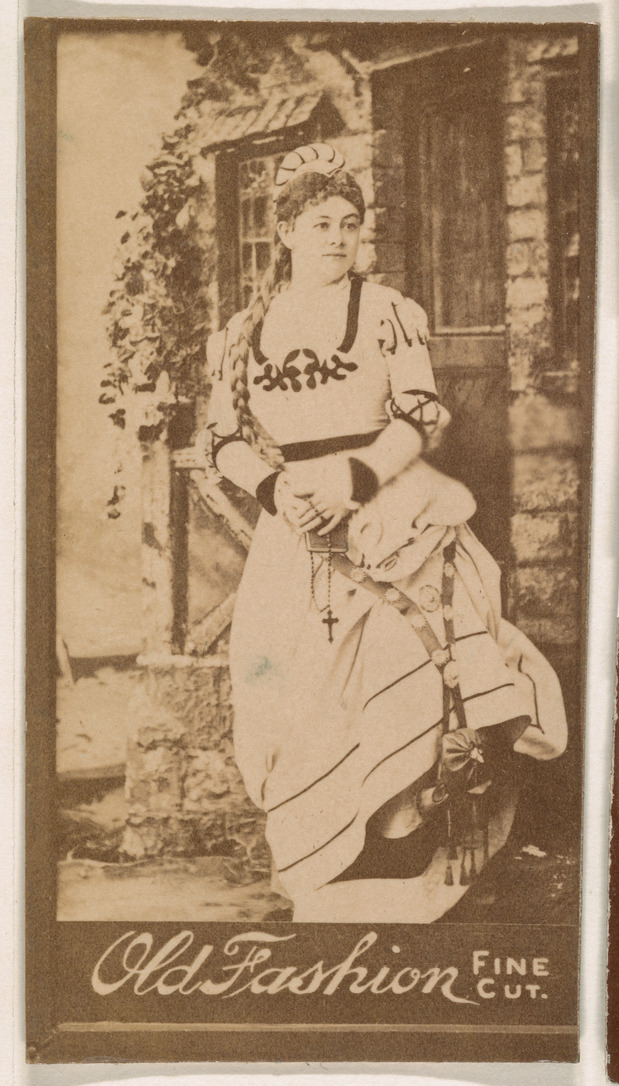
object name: photograph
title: Actress with long braid, from the Actresses series (N664) promoting Old Fashion Fine Cut Tobacco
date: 1888-1890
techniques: albumen silver print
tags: portraits,women,actresses